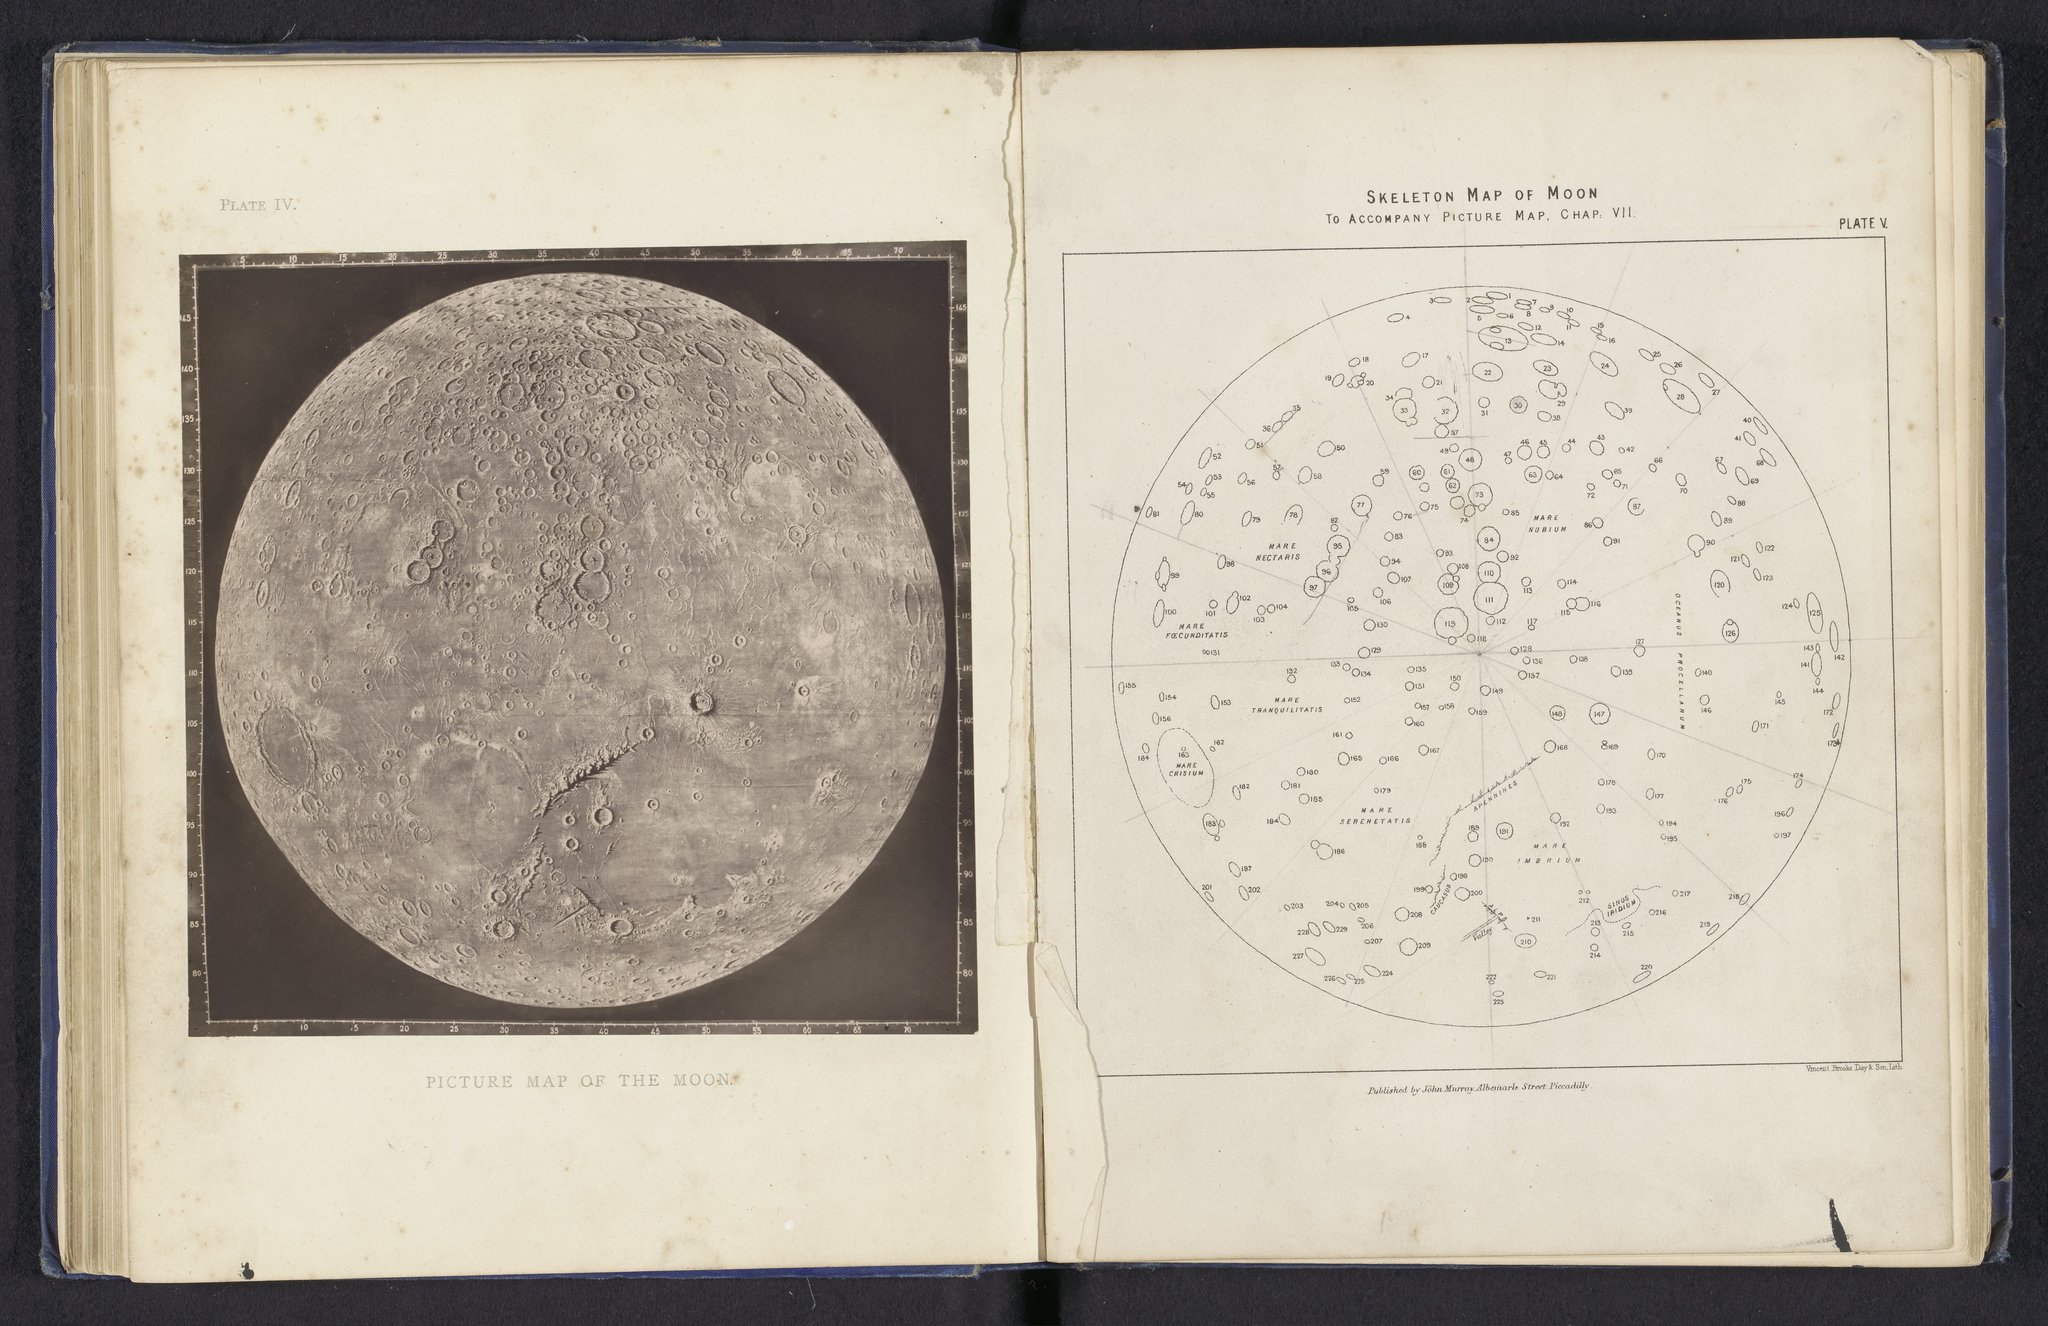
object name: print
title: Skeleton map of the moon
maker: john murray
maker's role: publisher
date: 1870-1873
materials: paper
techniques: lithograph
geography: united kingdom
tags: full moon, moon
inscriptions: name: ‘Published by John Murray, Albemarle Street Piccadilly.’, inscription: ‘To accompagny picture map, Chap. VII.’, number: ‘Plate V.’